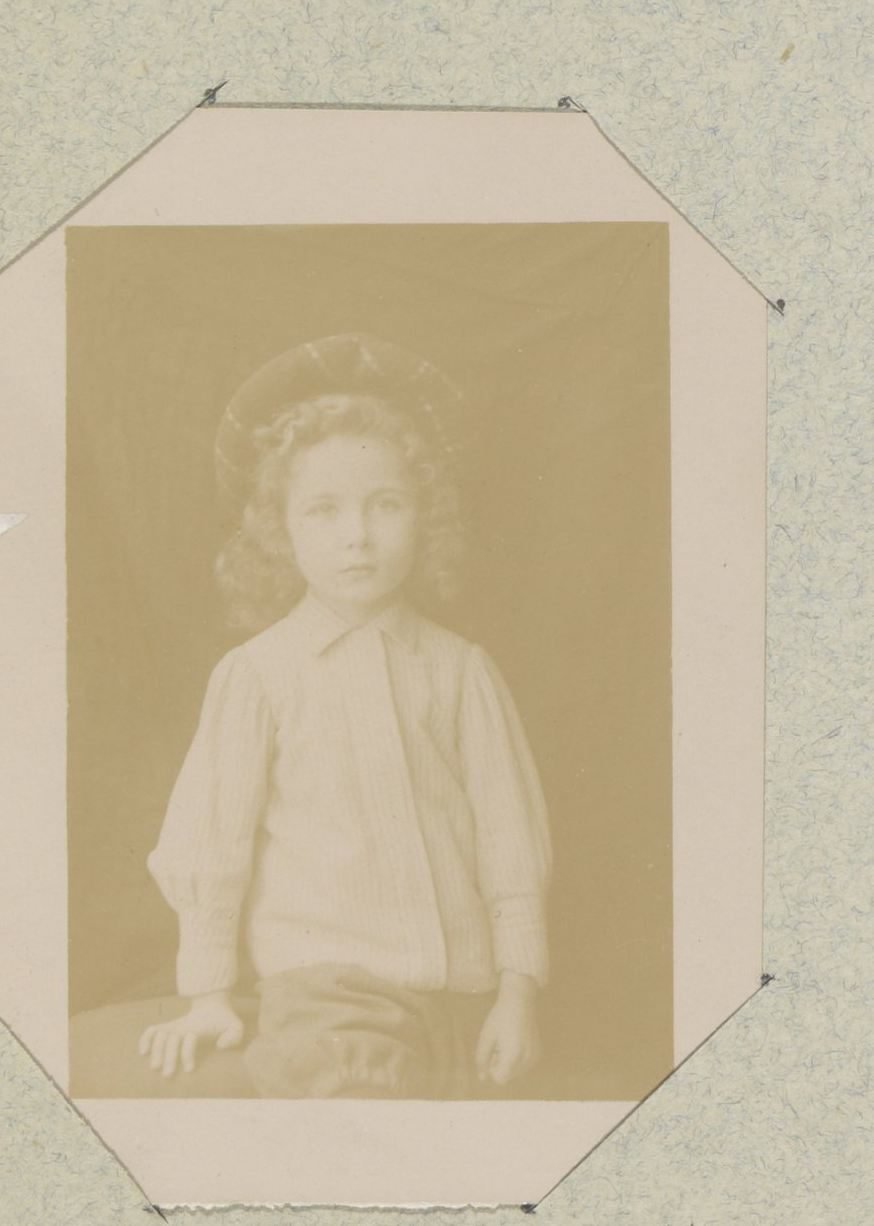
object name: photograph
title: Portret van een jong kind met een muts, vermoedelijk in Frankrijk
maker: Anonymous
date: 1890-1900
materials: paper, photographic support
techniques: daylight paper print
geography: france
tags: child, head-gear: hat, france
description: Onderdeel van Album van een Franse amateur met foto's van Frankrijk, Algerije, Palmyra, de Wereldtentoonstelling van 1900 en van bekende Fransen.